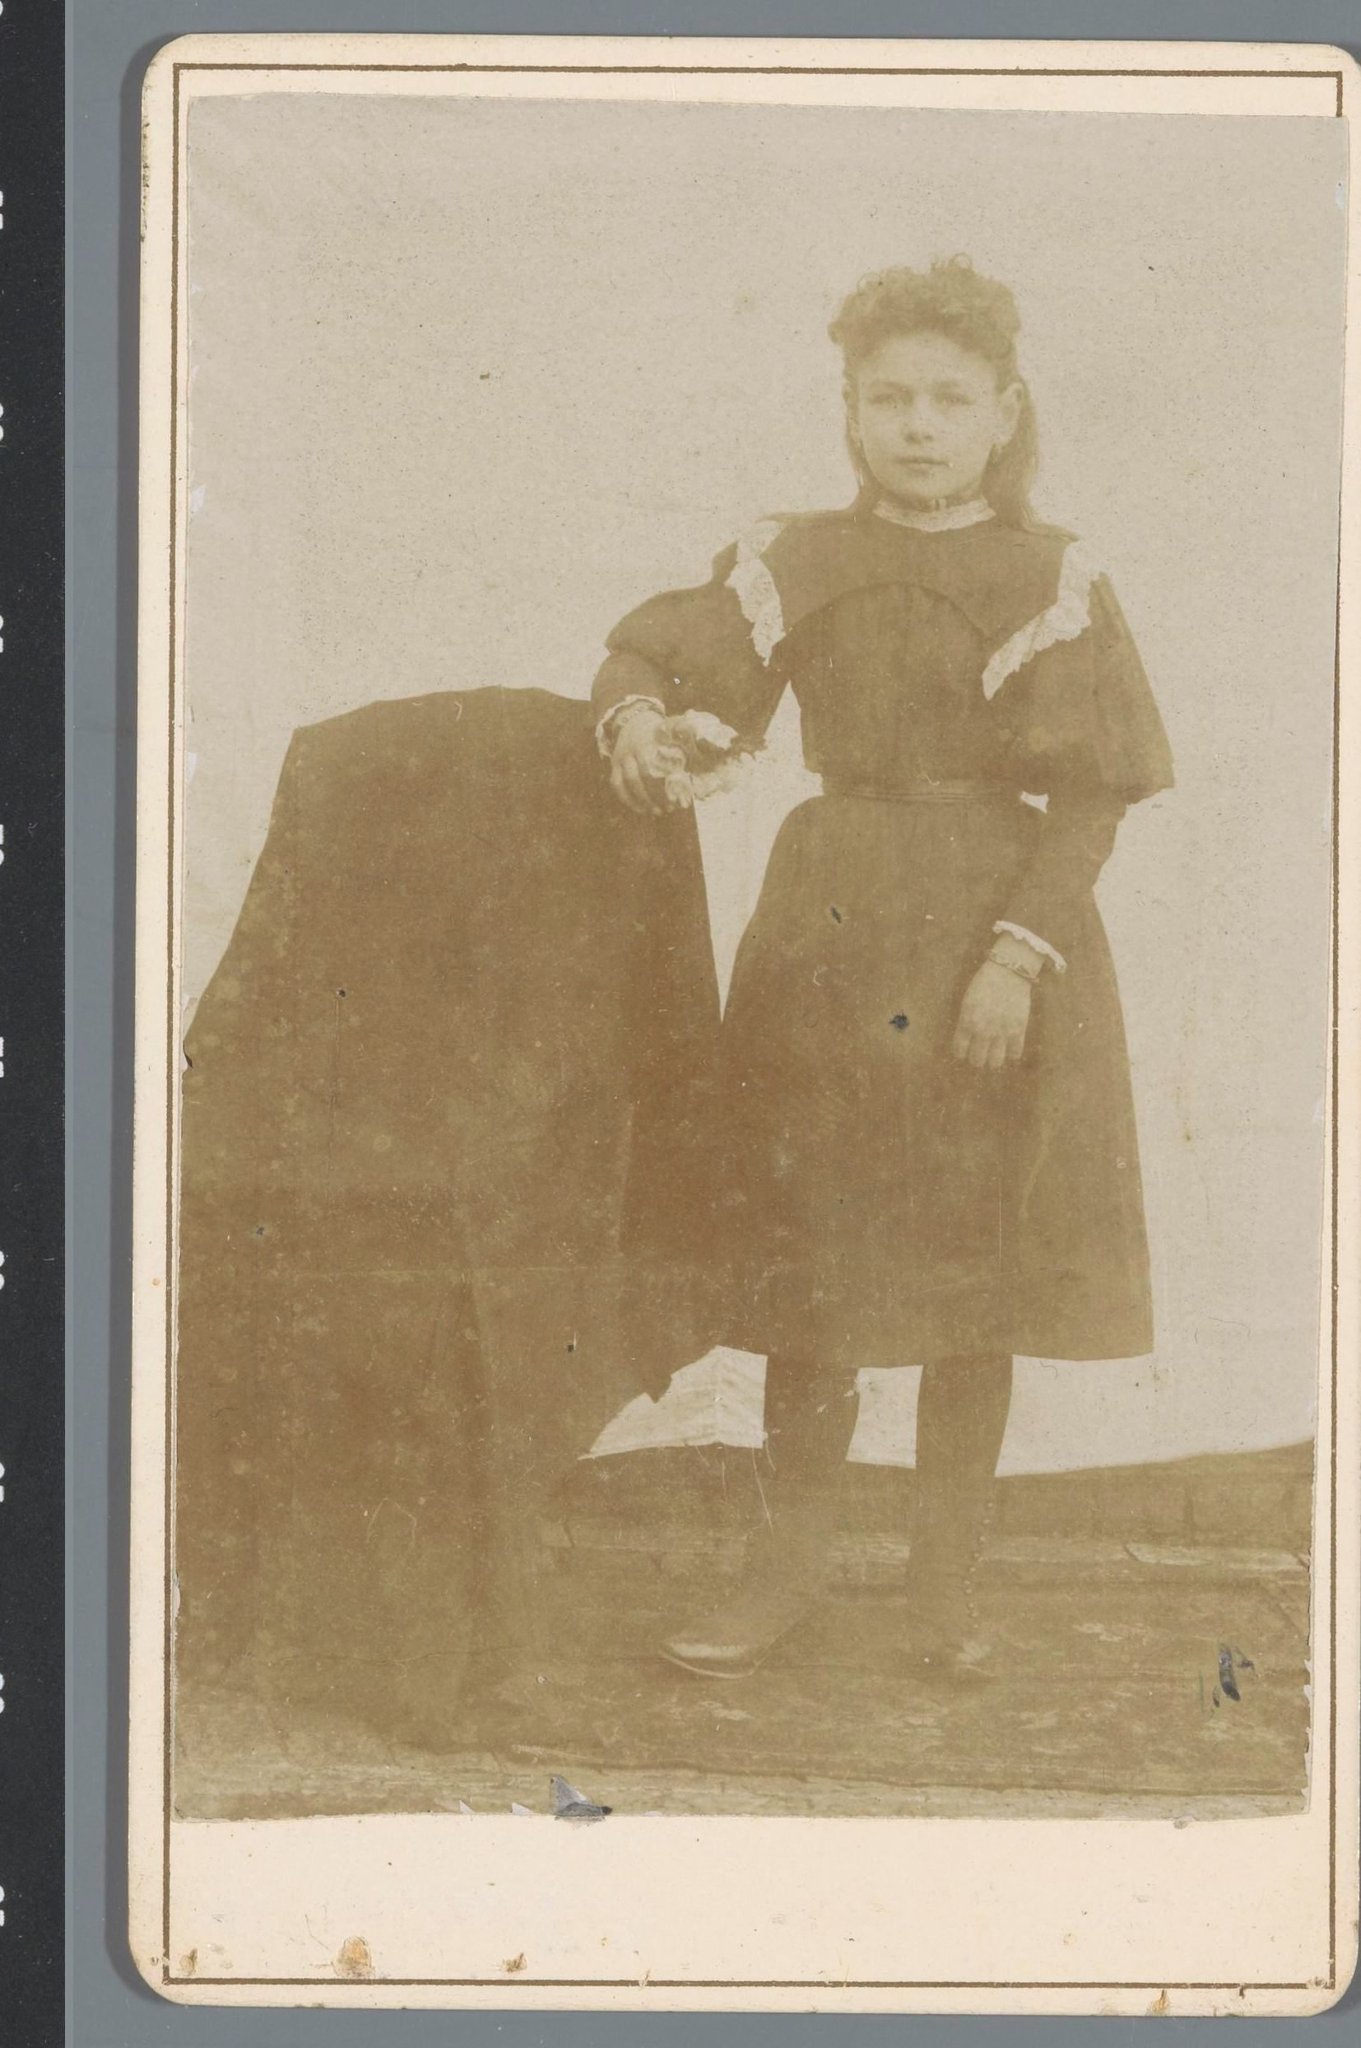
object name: carte de visite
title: Portret van Geertje Pronk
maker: Anonymous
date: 1880-1910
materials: cardboard, paper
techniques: albumen print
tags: historical persons, girl (child between toddler and youth)